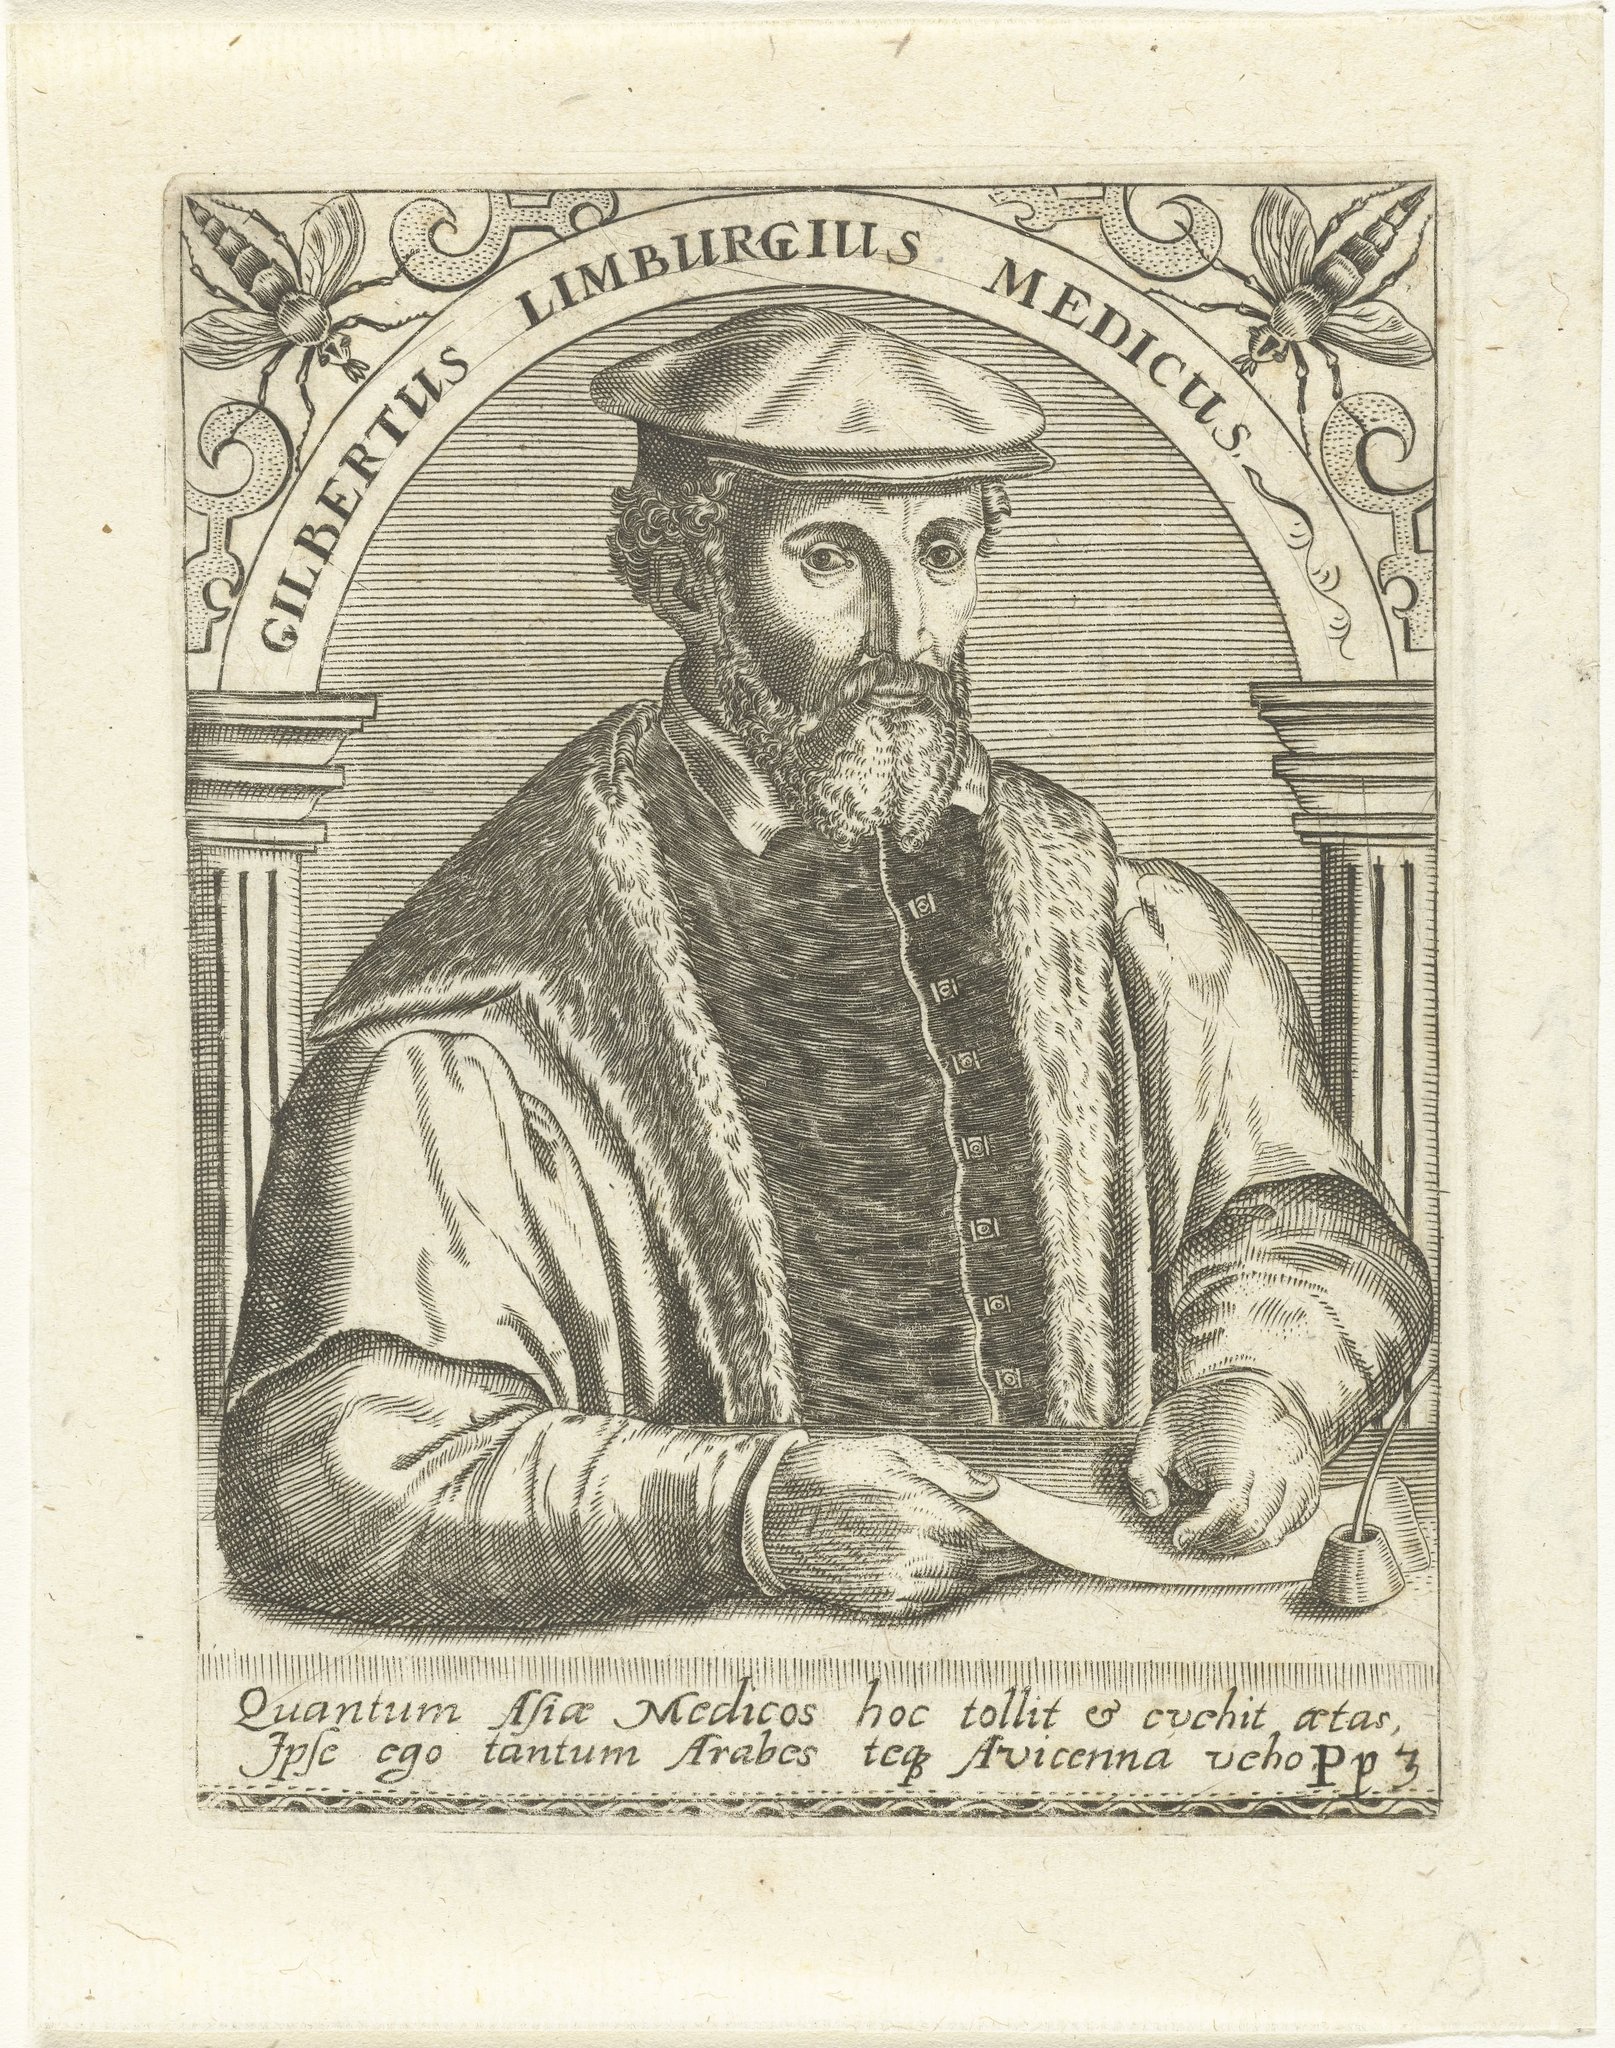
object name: book illustration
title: Gilbertus Limburgius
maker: jean jacques boissard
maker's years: 1528-1598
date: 1669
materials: paper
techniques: engraving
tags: arts, gilbert fuchs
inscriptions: collector's mark: Lugt 2228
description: Gemaakt voor: J.J. Boissard, Icones virorum illustrium doctrina &c eruditione praestanti um contines. Frankfurt am Main: de Bry, 1597-1599. Opnieuw gebruikt in: J.J.Boissard, Bibliotheca chalcographica, hoc est Virtute et eruditione clarorum Virorum Imagines. Heidelberg: Clemens Ammon, 1669 (te herkennen aan de toegevoegde signatuur in de rechter onderhoek: 2P3).